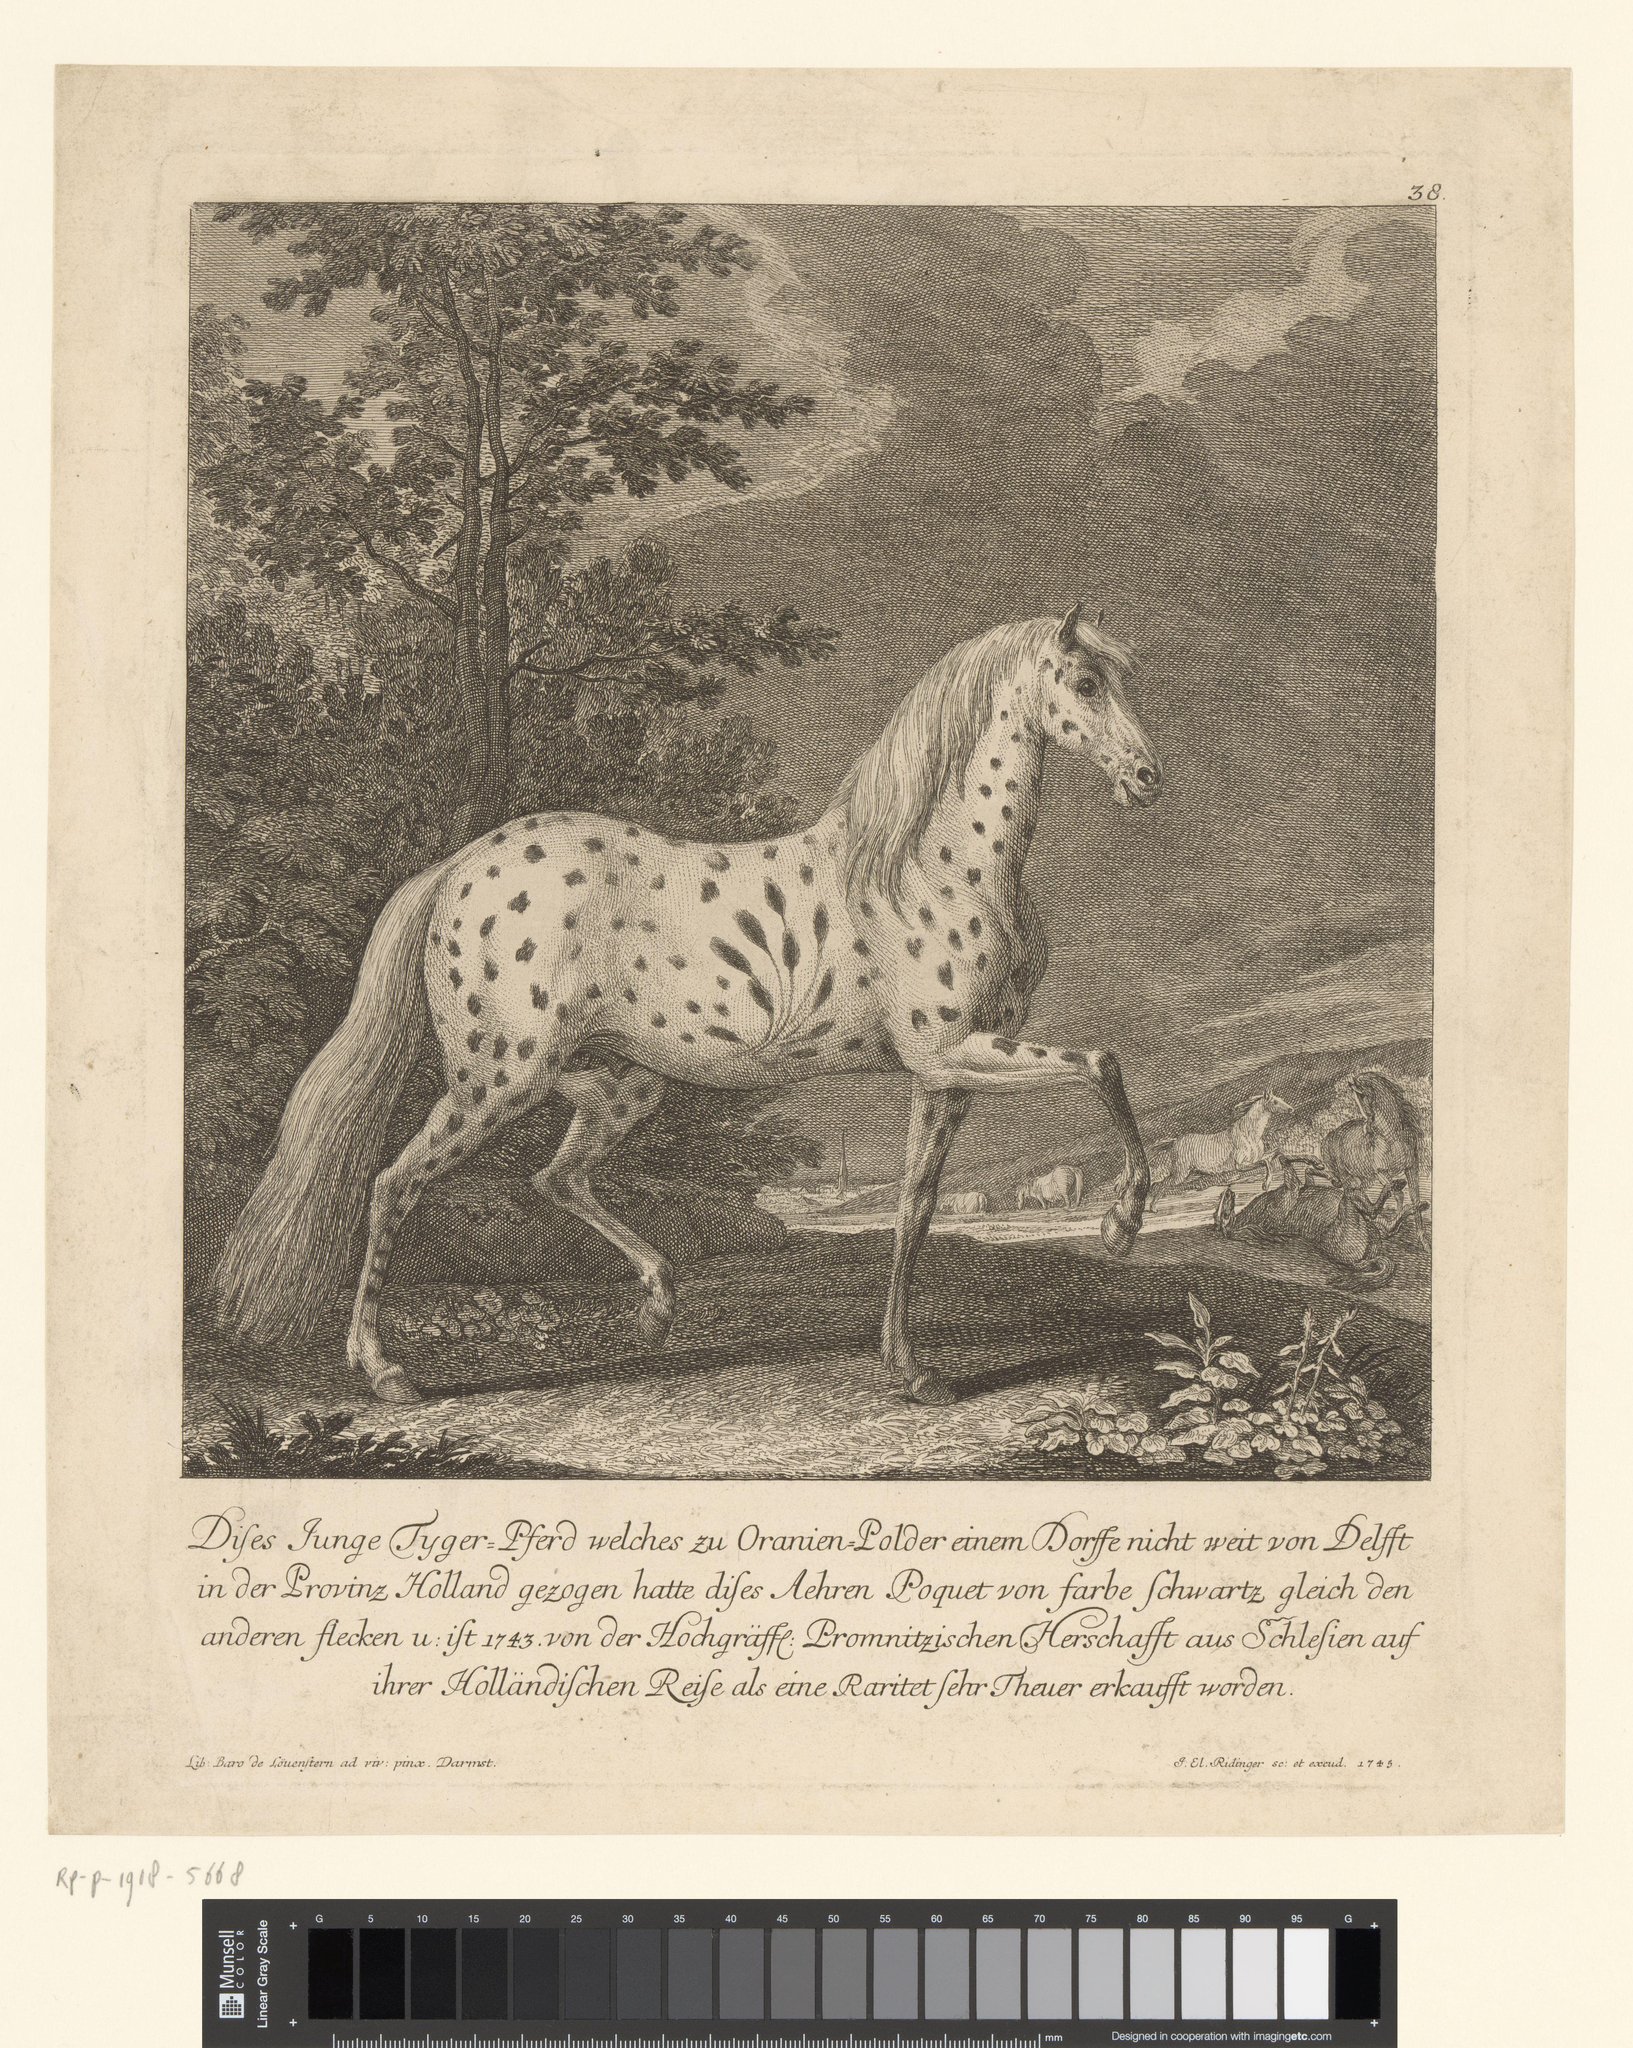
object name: print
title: De 100 meest wonderlijke herten en andere dieren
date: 1745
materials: paper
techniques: etching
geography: darmstadt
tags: horse, delft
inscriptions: collector's mark: Lugt 2228